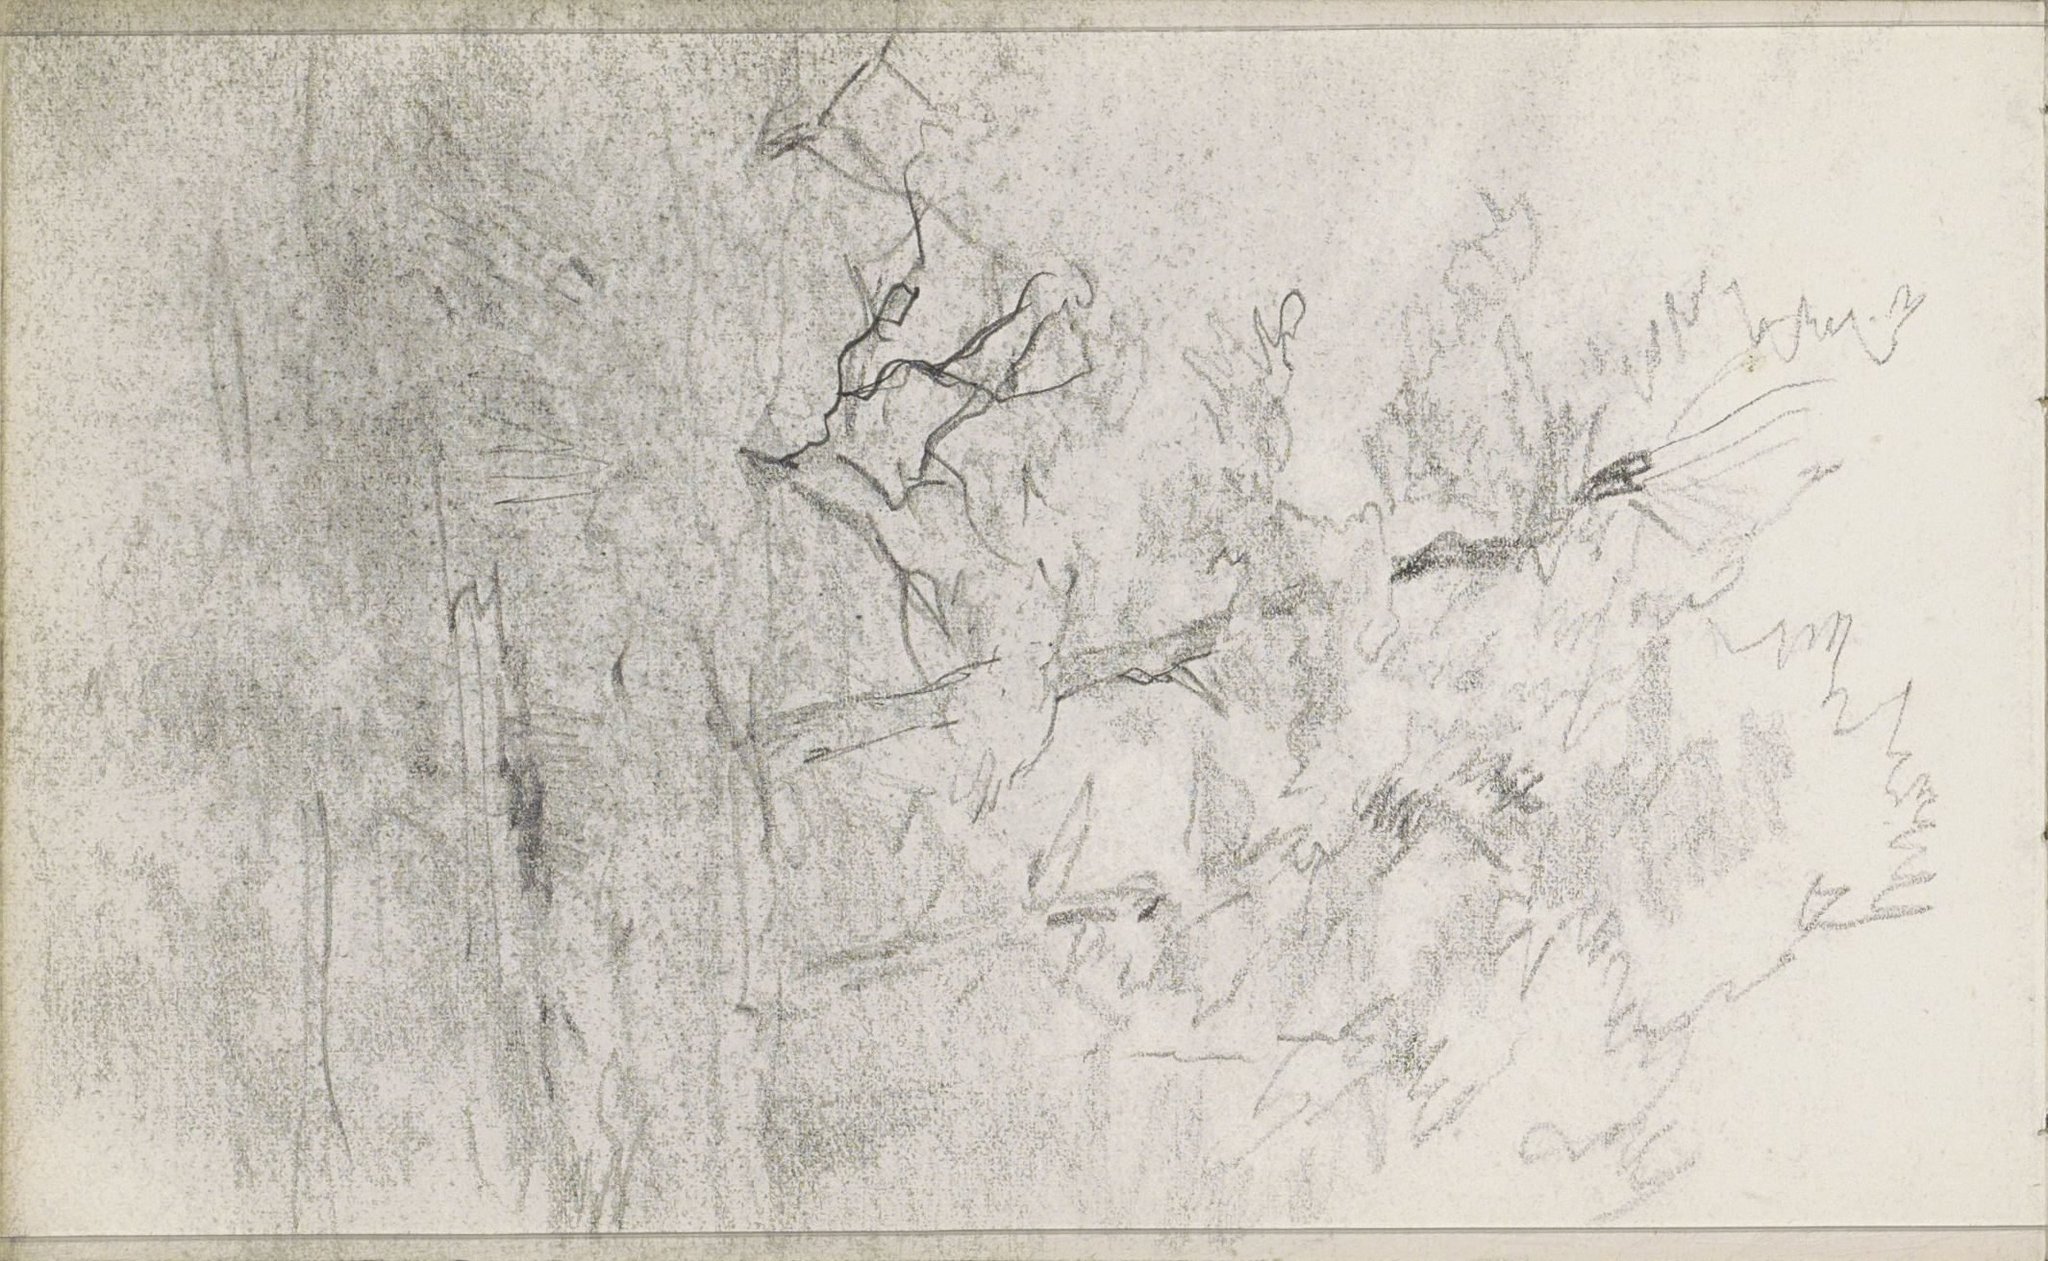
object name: sketchbook leaf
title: Bomen in de wind aan een waterkant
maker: anton mauve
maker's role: draughtsman, painter, print maker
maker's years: 1838-1888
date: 1848-1888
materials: paper, pencil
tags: trees, landscapes with waters, waterscapes, seascapes (in the temperate zone)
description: Blad 23 verso uit een schetsboek met 43 bladen.